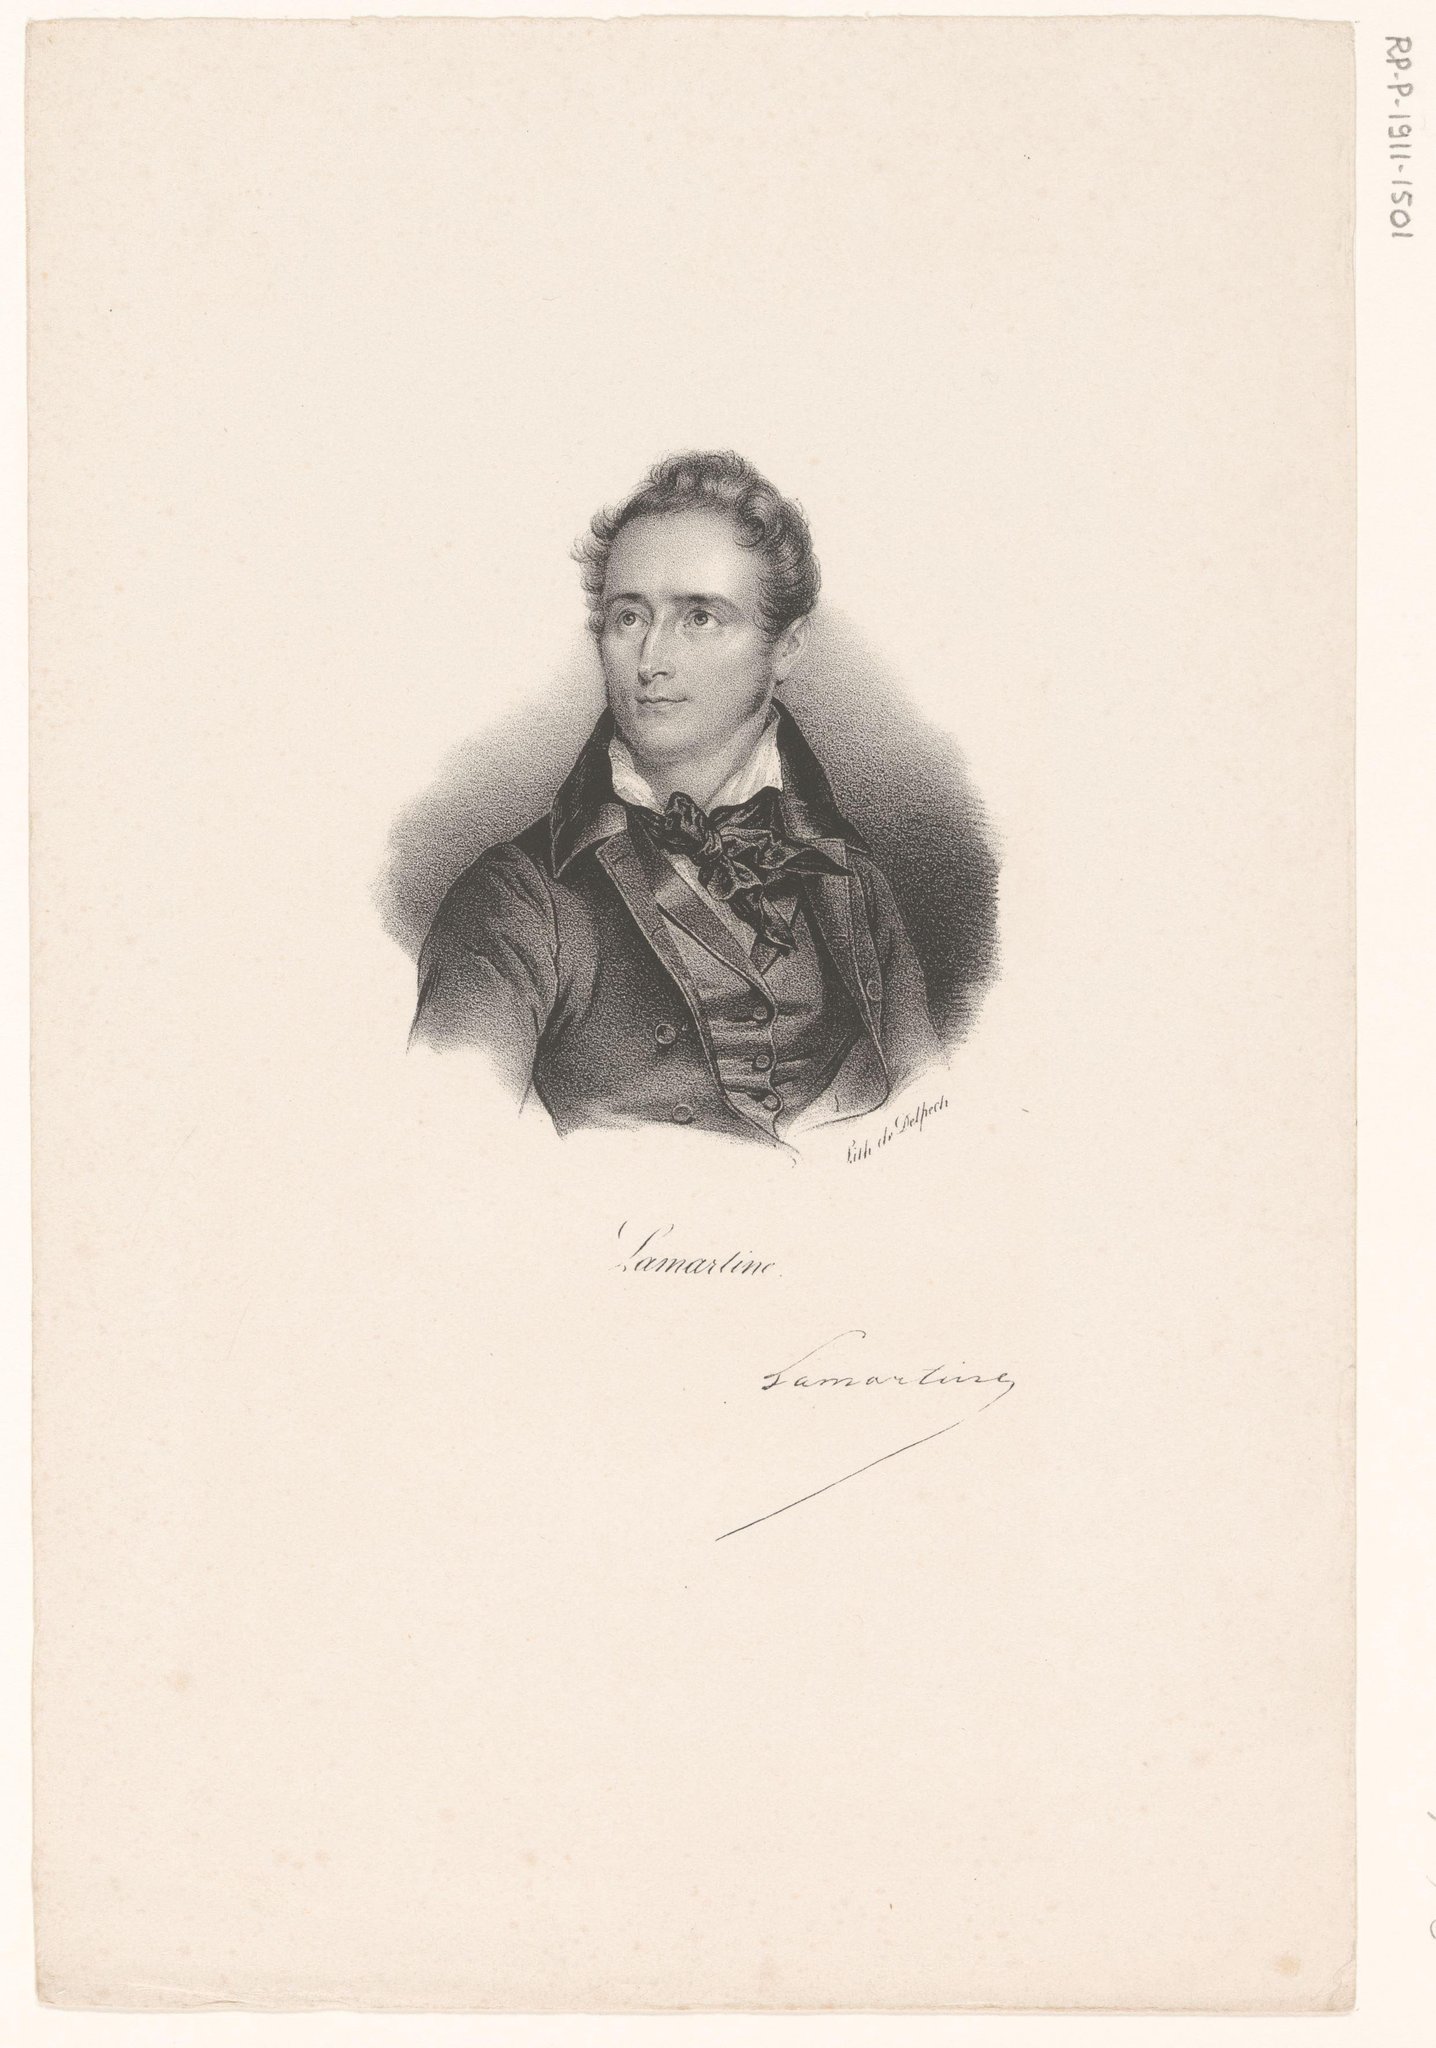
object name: print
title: Portret van Alphonse de Lamartine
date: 1818-1842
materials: paper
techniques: lithograph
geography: paris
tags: paris, historical persons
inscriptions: collector's mark: Lugt 2228a